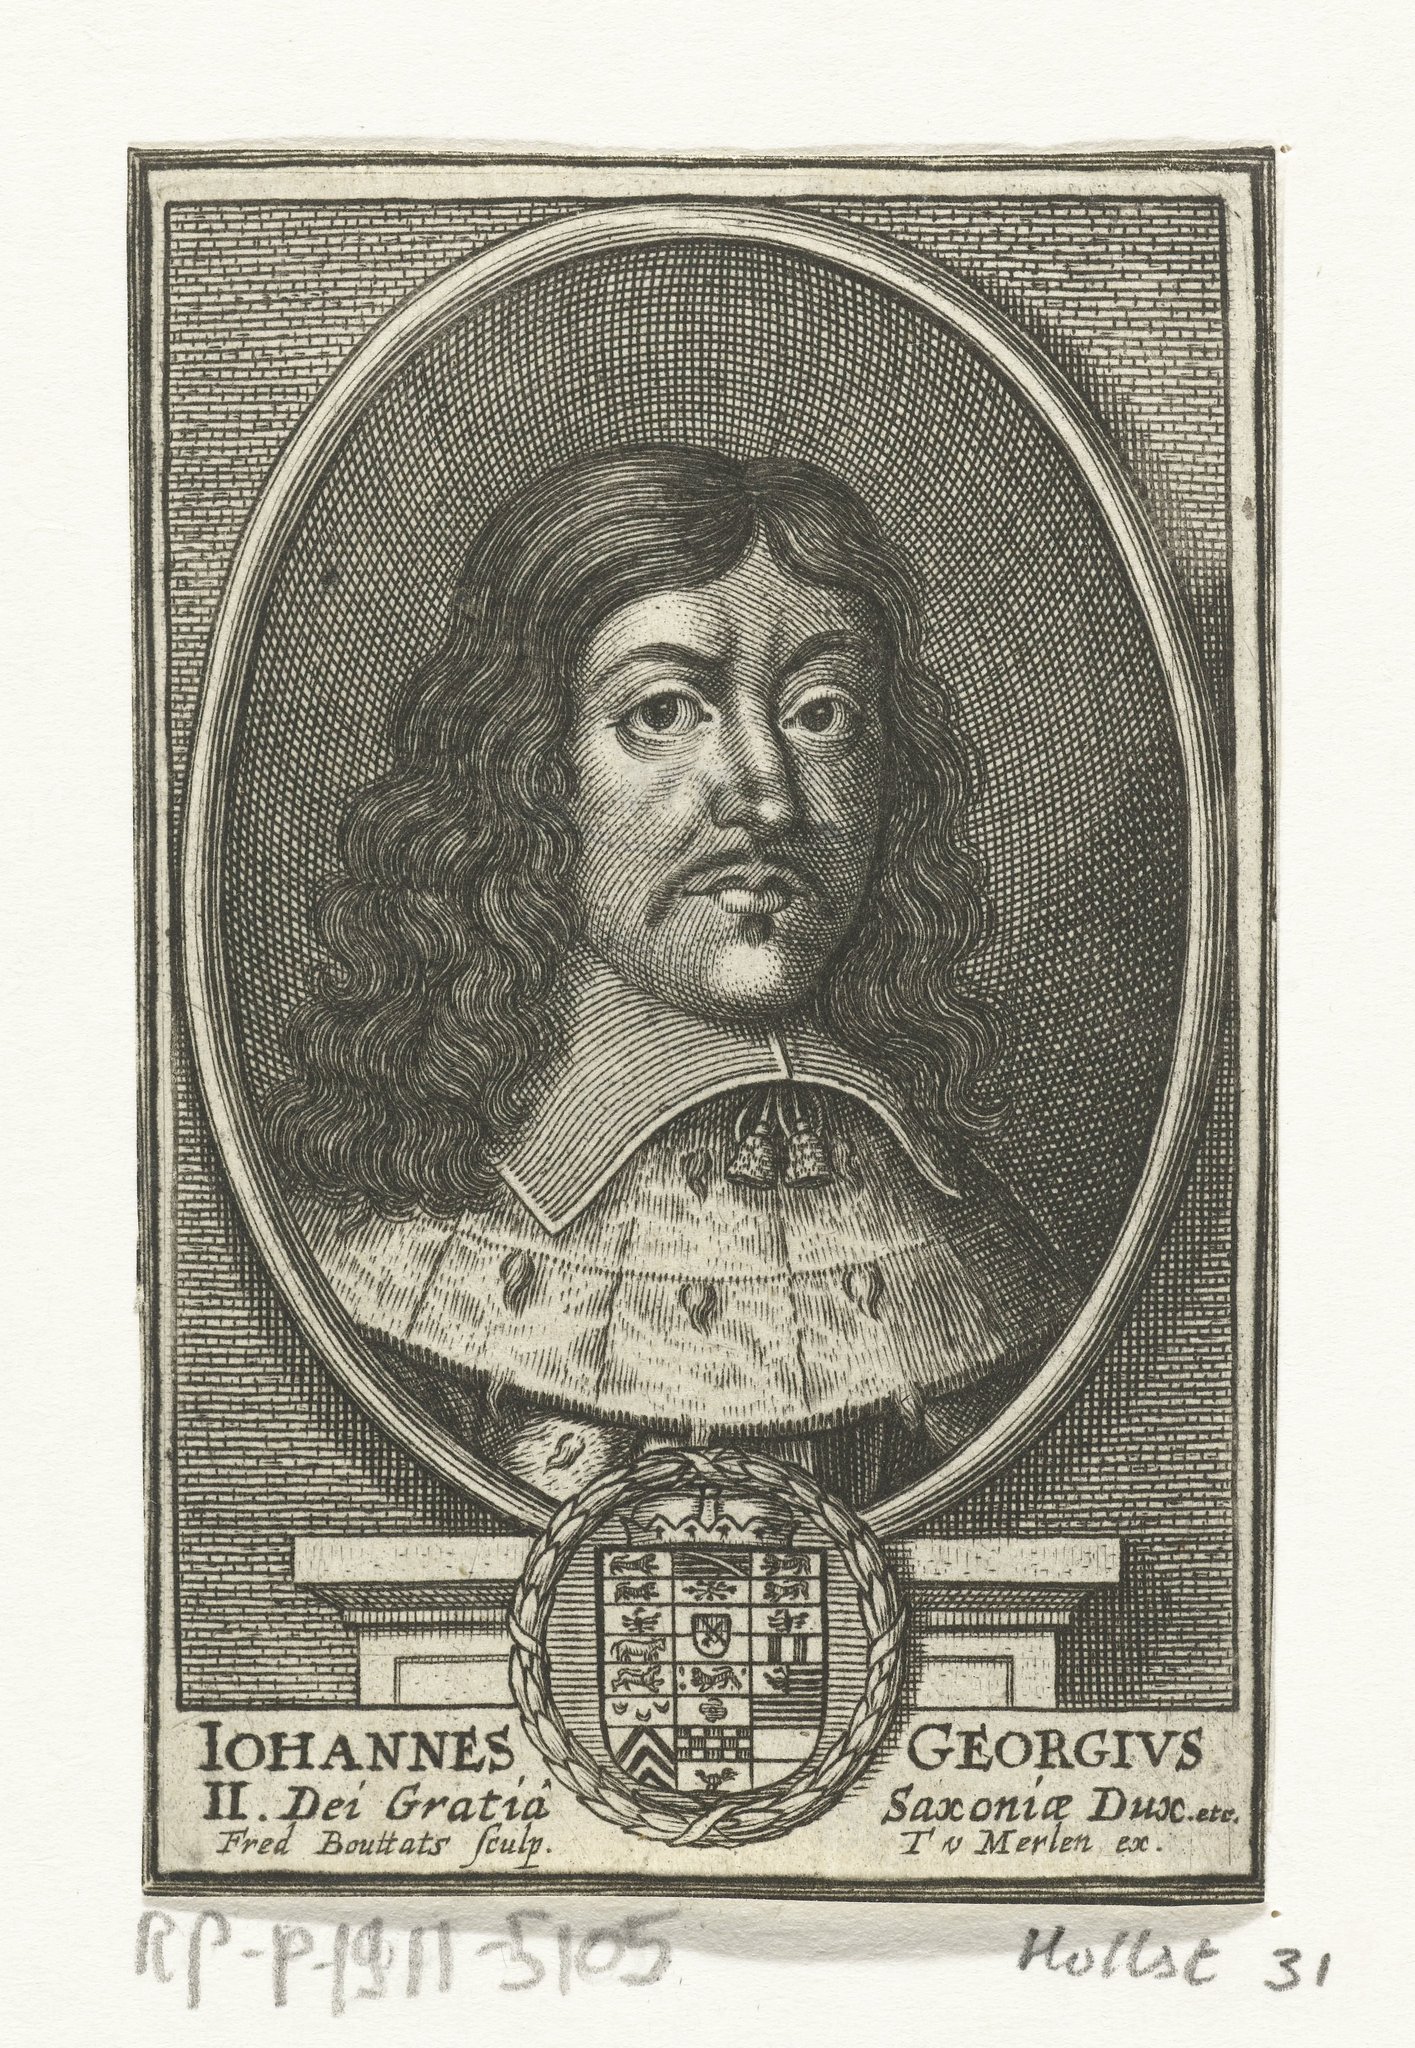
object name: print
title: Portretten van staatslieden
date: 1656-1676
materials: paper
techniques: engraving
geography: antwerp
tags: freiberg, keurvorst, keurvorst van saksen johan georg ii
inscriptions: collector's mark: Lugt 2228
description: Portret in een ovale lijst van Johan Georg II, keurvorst van Saksen. Buste naar rechts. Johann George draagt een hermelijnen mantel. Het portret staat in een rechthoekig kader. De prent heeft een Latijns onderschrift met de naam van de geportretteerde.